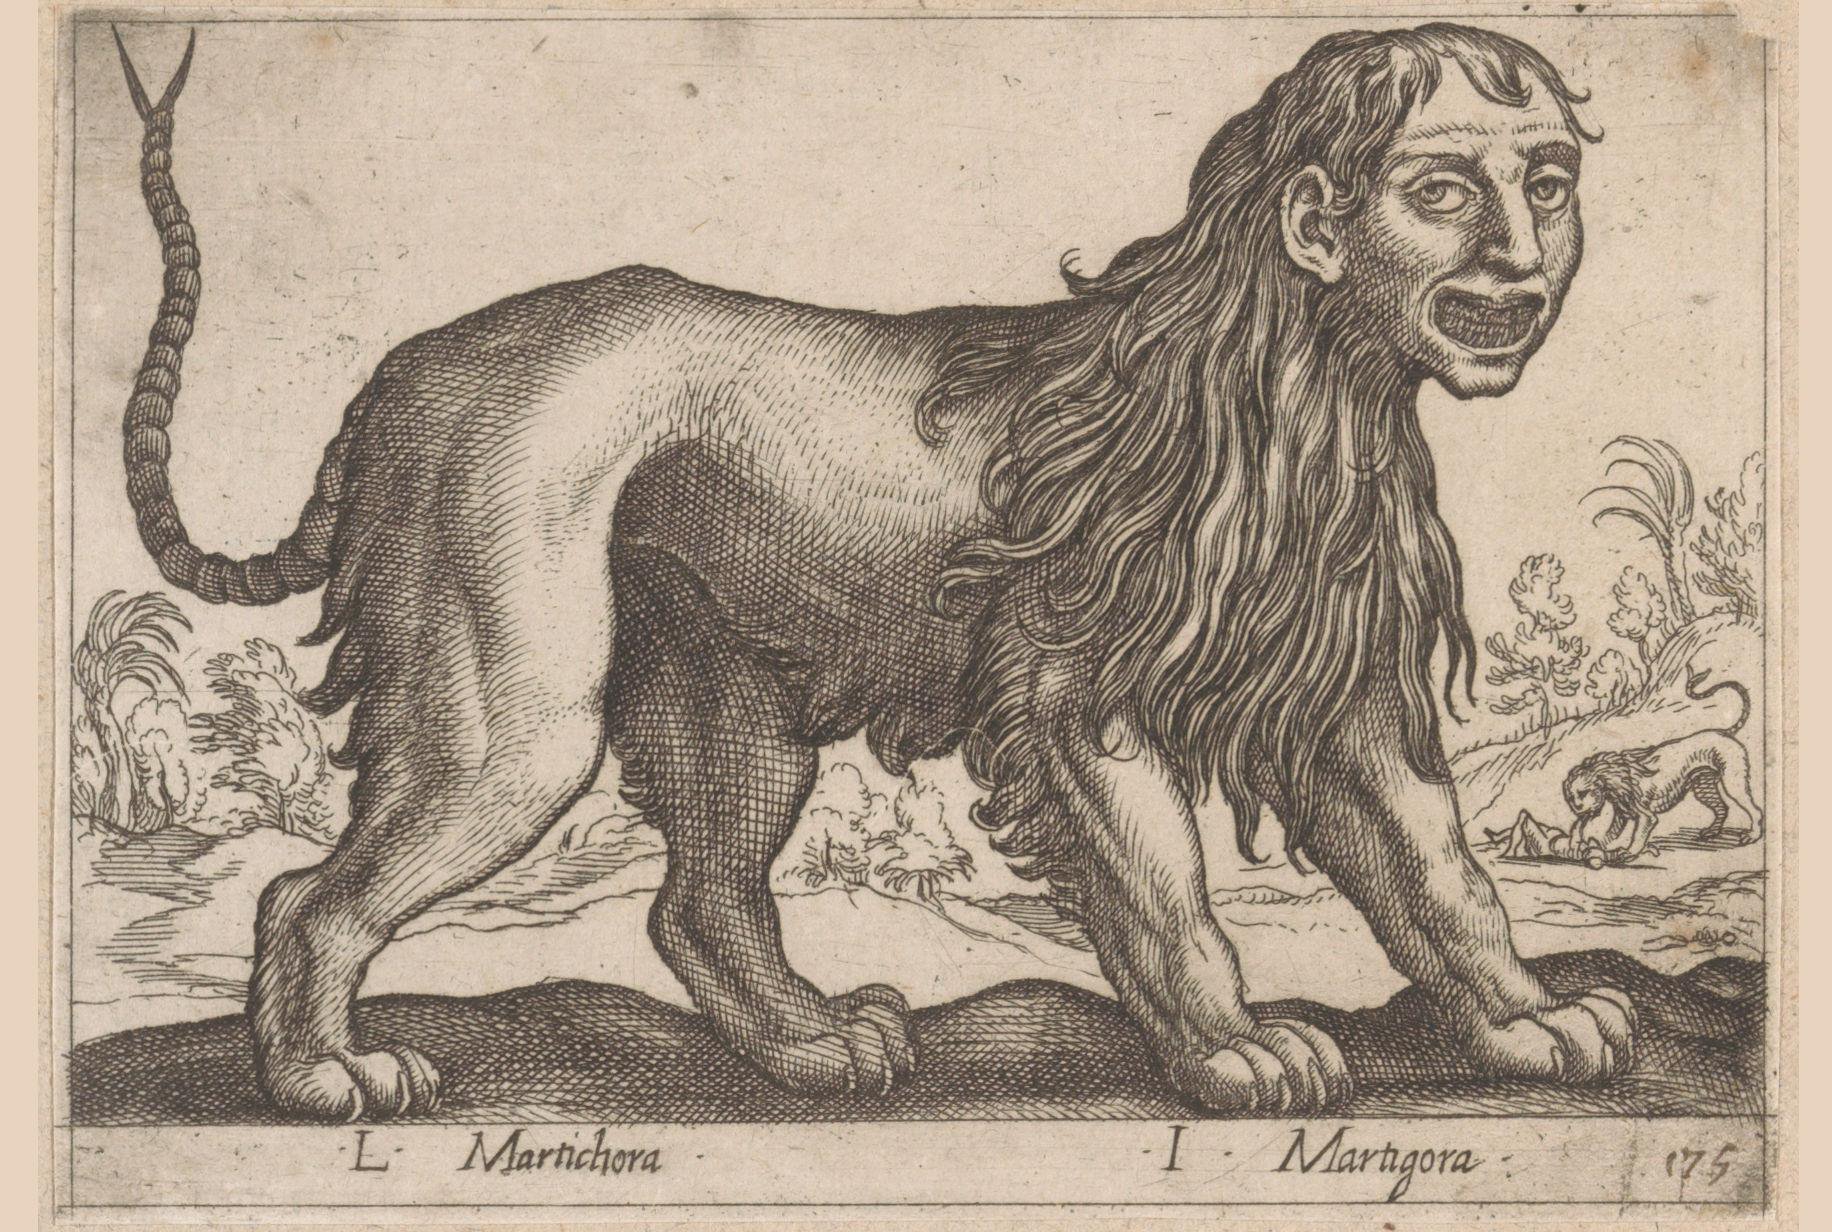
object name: print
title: Dieren en fabelwezens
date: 1565-1630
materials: paper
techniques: etching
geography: italy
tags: monsters of mixed human and animal shape; 'mostri' (ripa), mis-shapen animals; monsters, beasts of prey, predatory animals: lion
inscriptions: collector's mark: Lugt 11, number: ‘175’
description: Deze prent maakt deel uit van een reeks prenten van dieren door Antonio Tempesta. Bekend is dat een tweede staat (met nummering) van deze serie is uitgegeven door Giovanni Giacomo de' Rossi in 1650. Onbekend is wie de eerste staat heeft uitgegeven en wanneer.